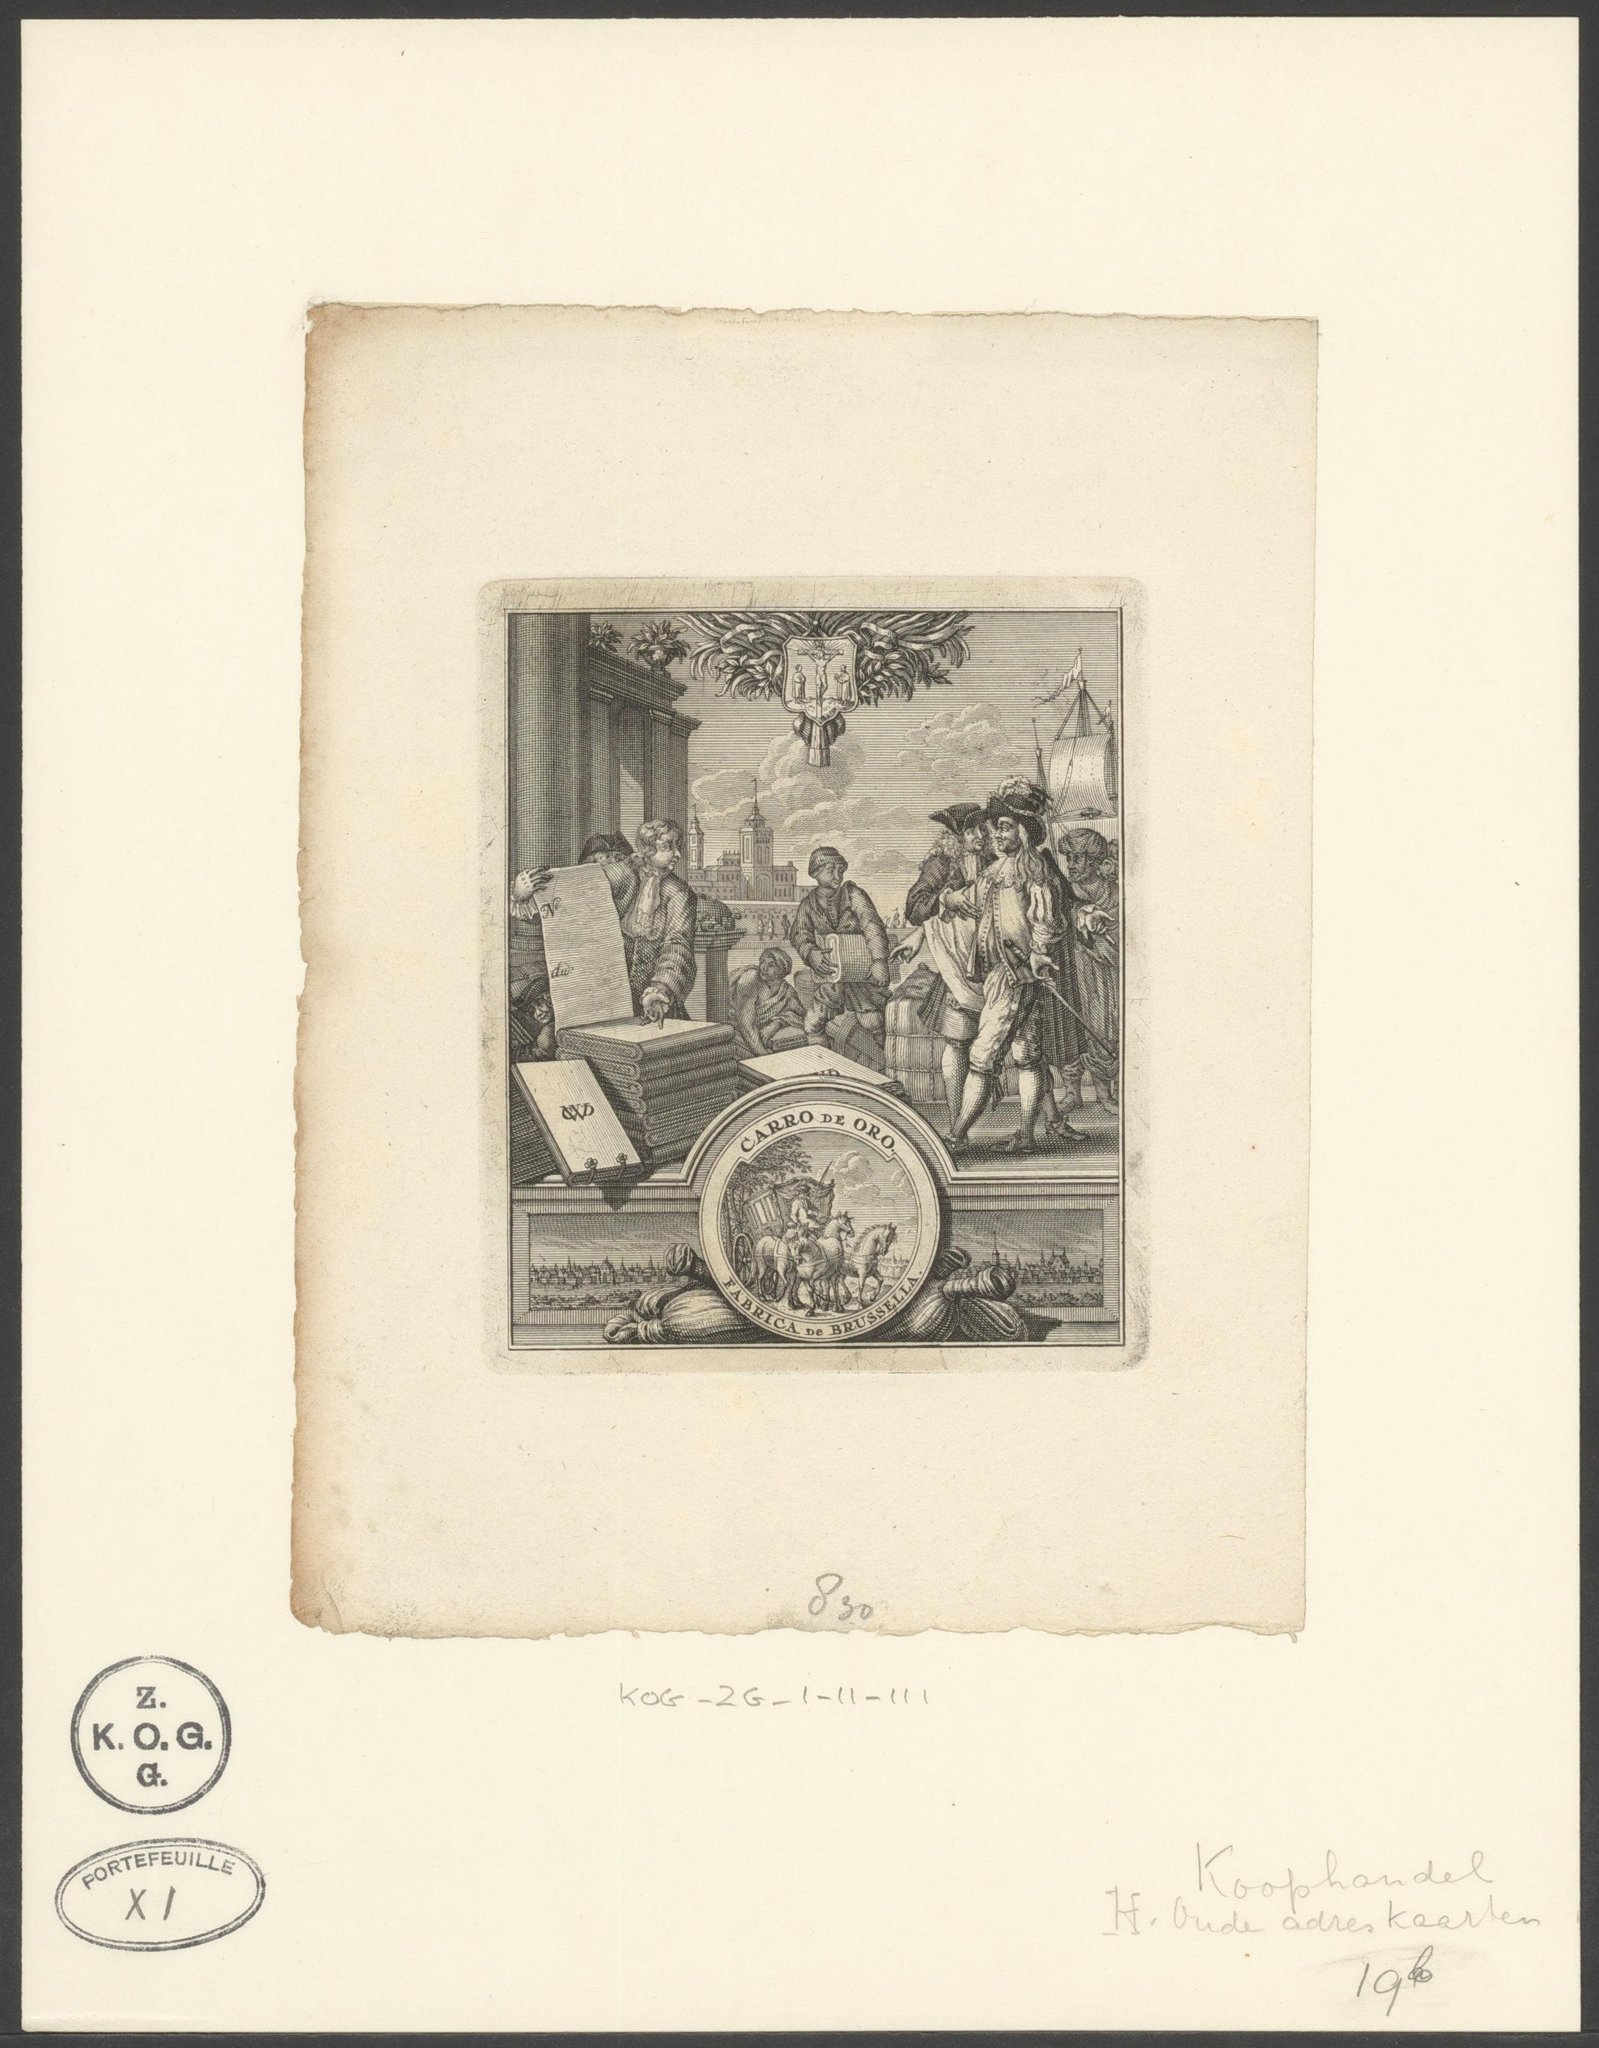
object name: business card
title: Handelsetiket van een lakenfabriek te Brussel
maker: Anonymous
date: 1700-1799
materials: paper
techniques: engraving, etching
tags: trade-company, materials ~ textile industry, textile fabric, cloth, brussels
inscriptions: collector's mark: Lugt 1641, stamp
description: Een man toont een stapel stoffen aan kooplieden. Op een van de stukken laken het monogram CWD. Midden boven een wapenschild met Christus aan het kruis. Onderaan een medaillon met een koets. Achter het medaillon een stadspanorama. Mogelijk de stad Brussel. Onderwerpsrubrieken binnen de Atlas Zeden en Gewoonten: Handel, nijverheid en verkeer, Koophandel, Veilingen, Makelaardij en Verzekeringswezen, Oude adreskaarten van winkels en fabrieken, reclame.